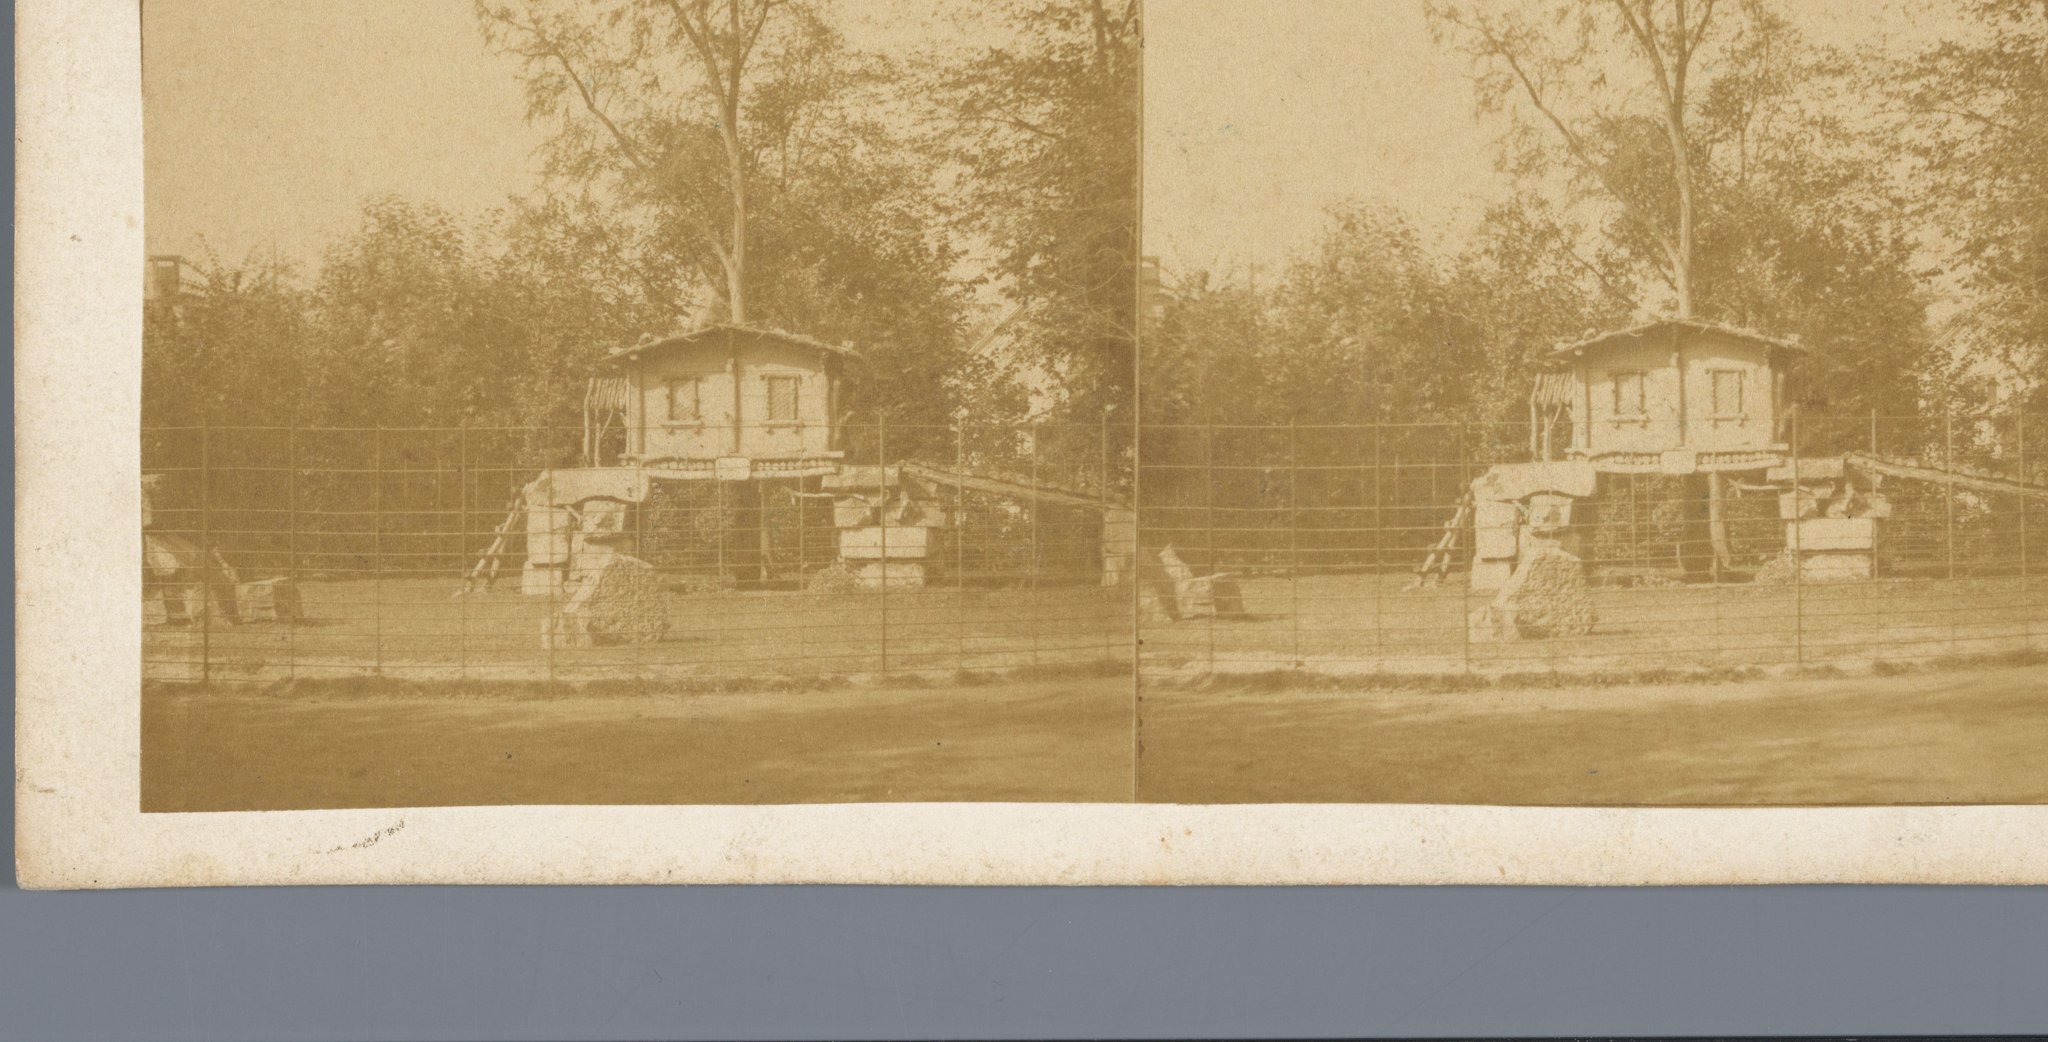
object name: stereograph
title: Natura Artis Magistra Amsterdam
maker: pieter oosterhuis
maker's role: draughtsman, print maker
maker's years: 1816-1885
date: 1857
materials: cardboard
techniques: albumen print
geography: amsterdam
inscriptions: label: ‘Boommarkt F 76’